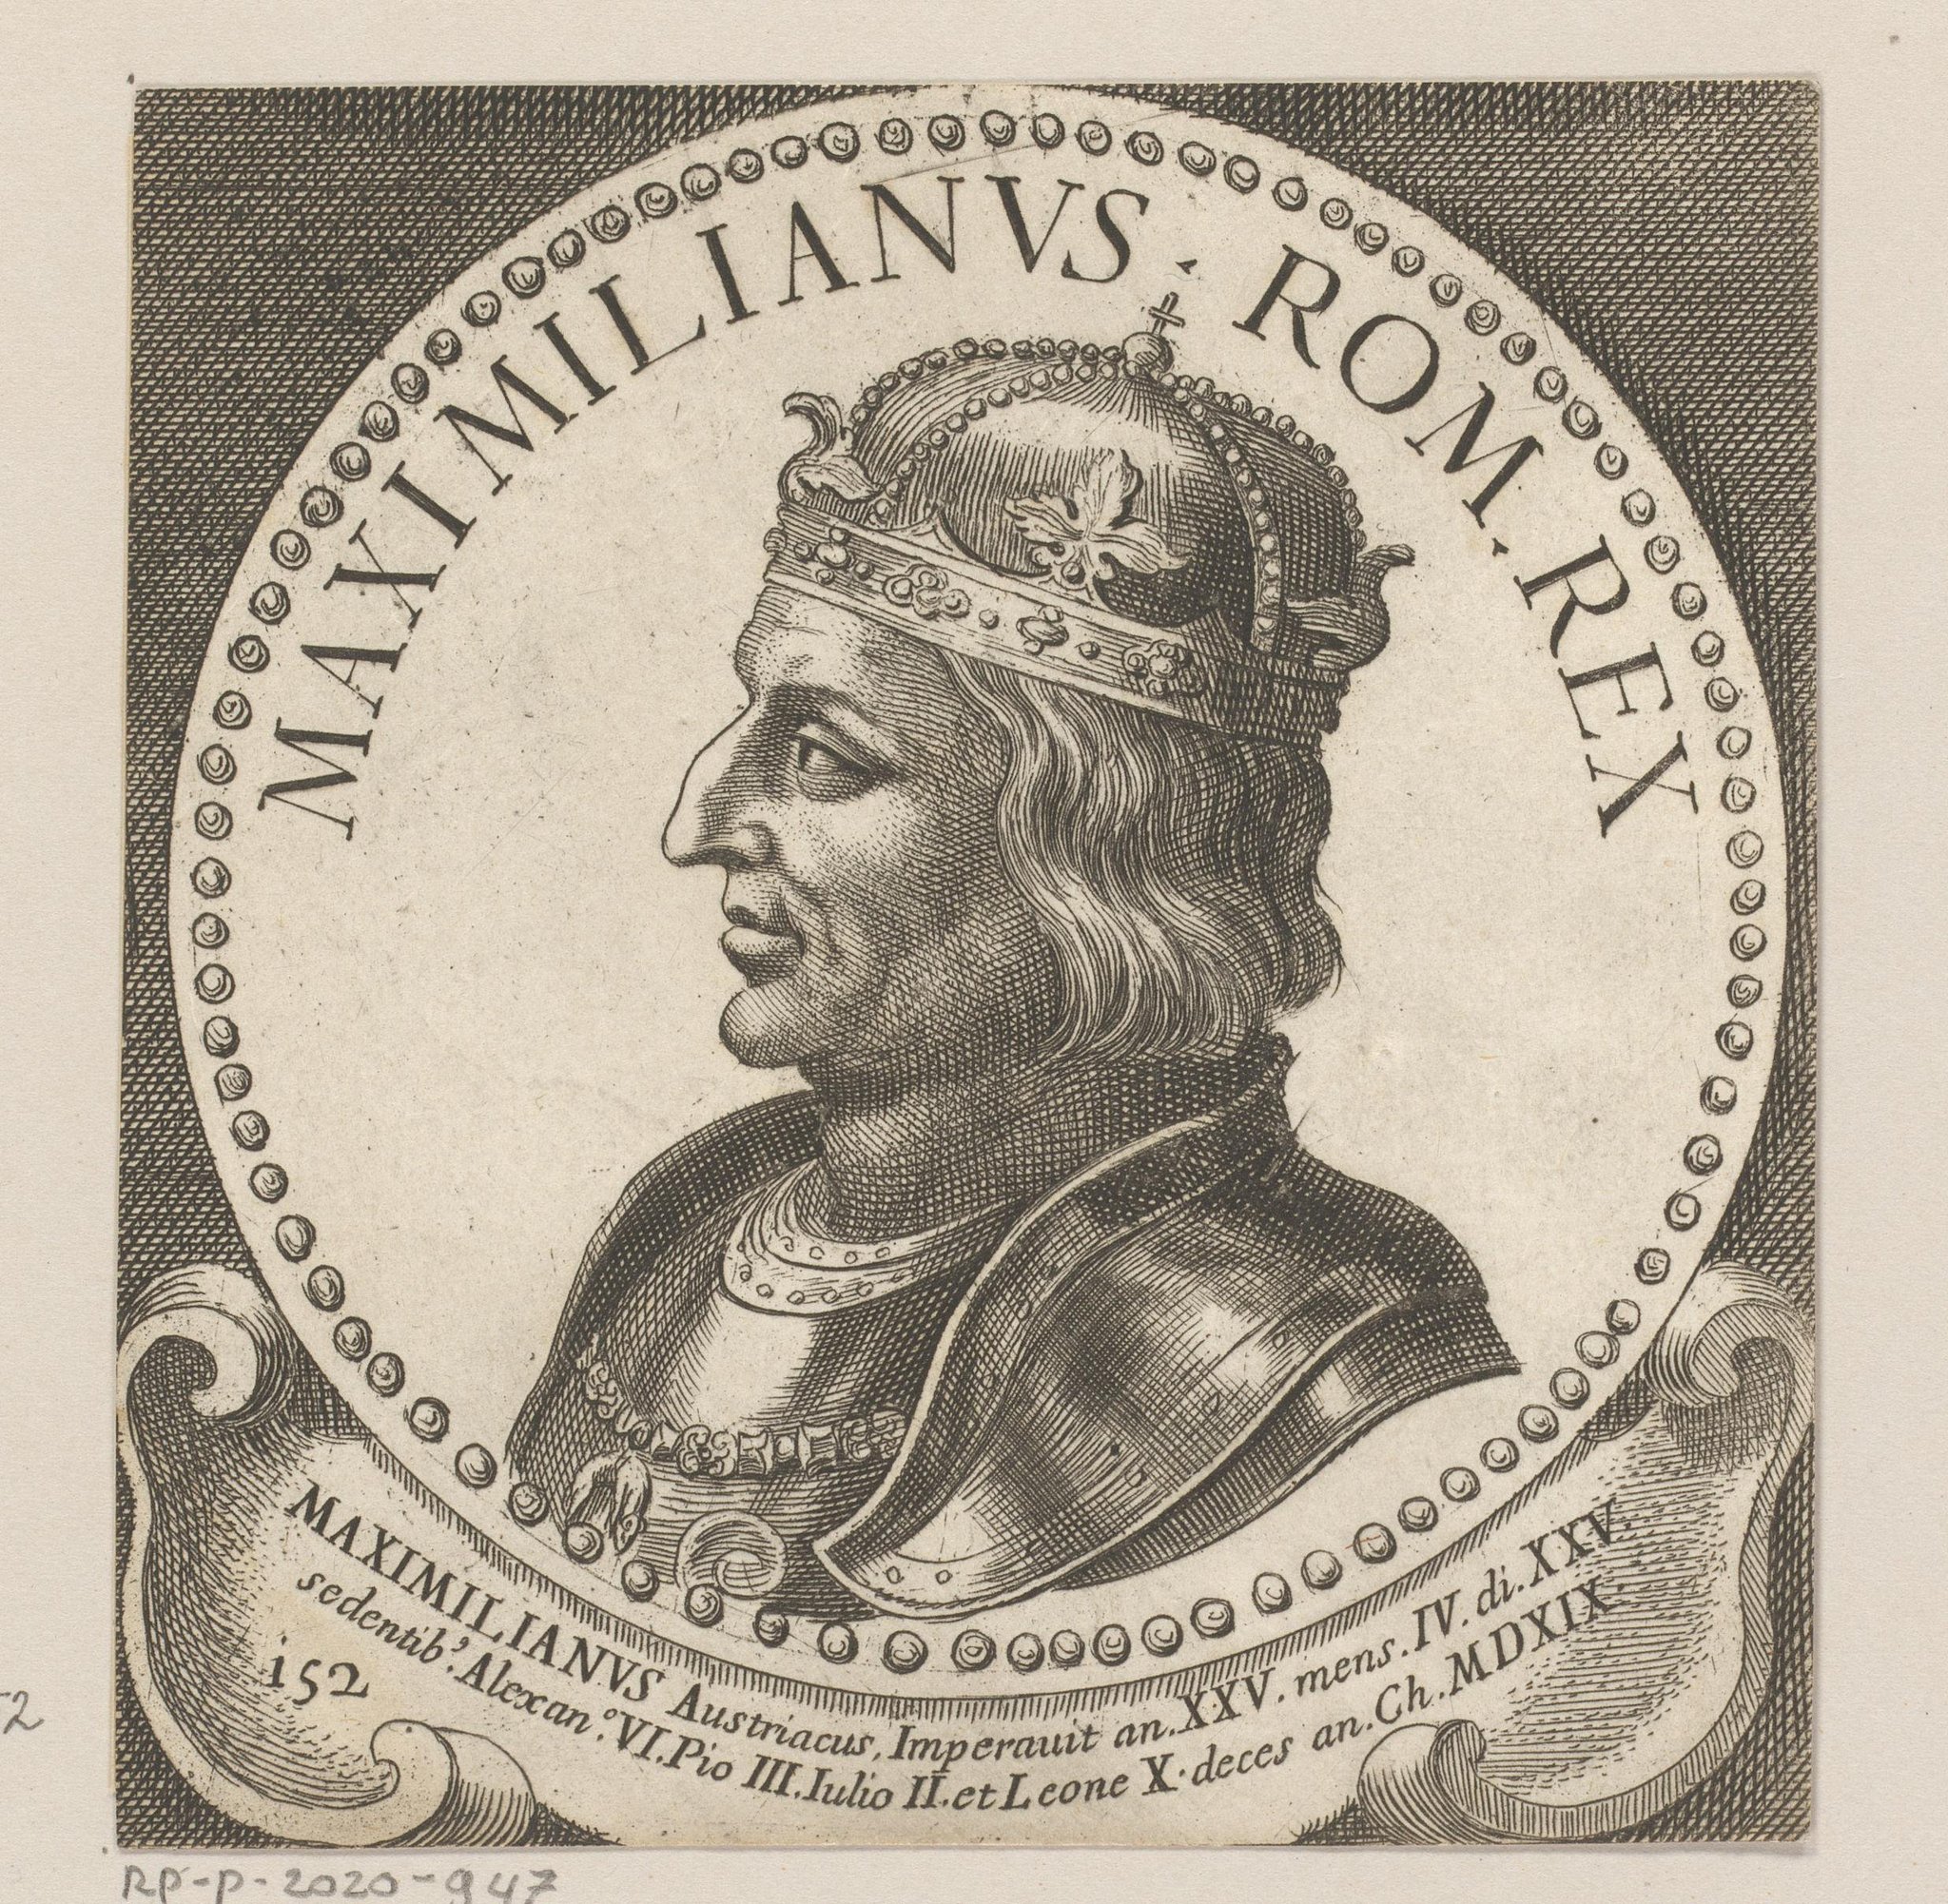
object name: print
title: Maximilianus. Rom. rex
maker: Anonymous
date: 1700-1799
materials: paper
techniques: engraving, etching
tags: maximilian i (holy roman emperor), crown (symbol of sovereignty), historical persons, emperor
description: In een cirkel met daaronder een cartouche met een Latijnse tekst. Linksonder genummerd: 152.